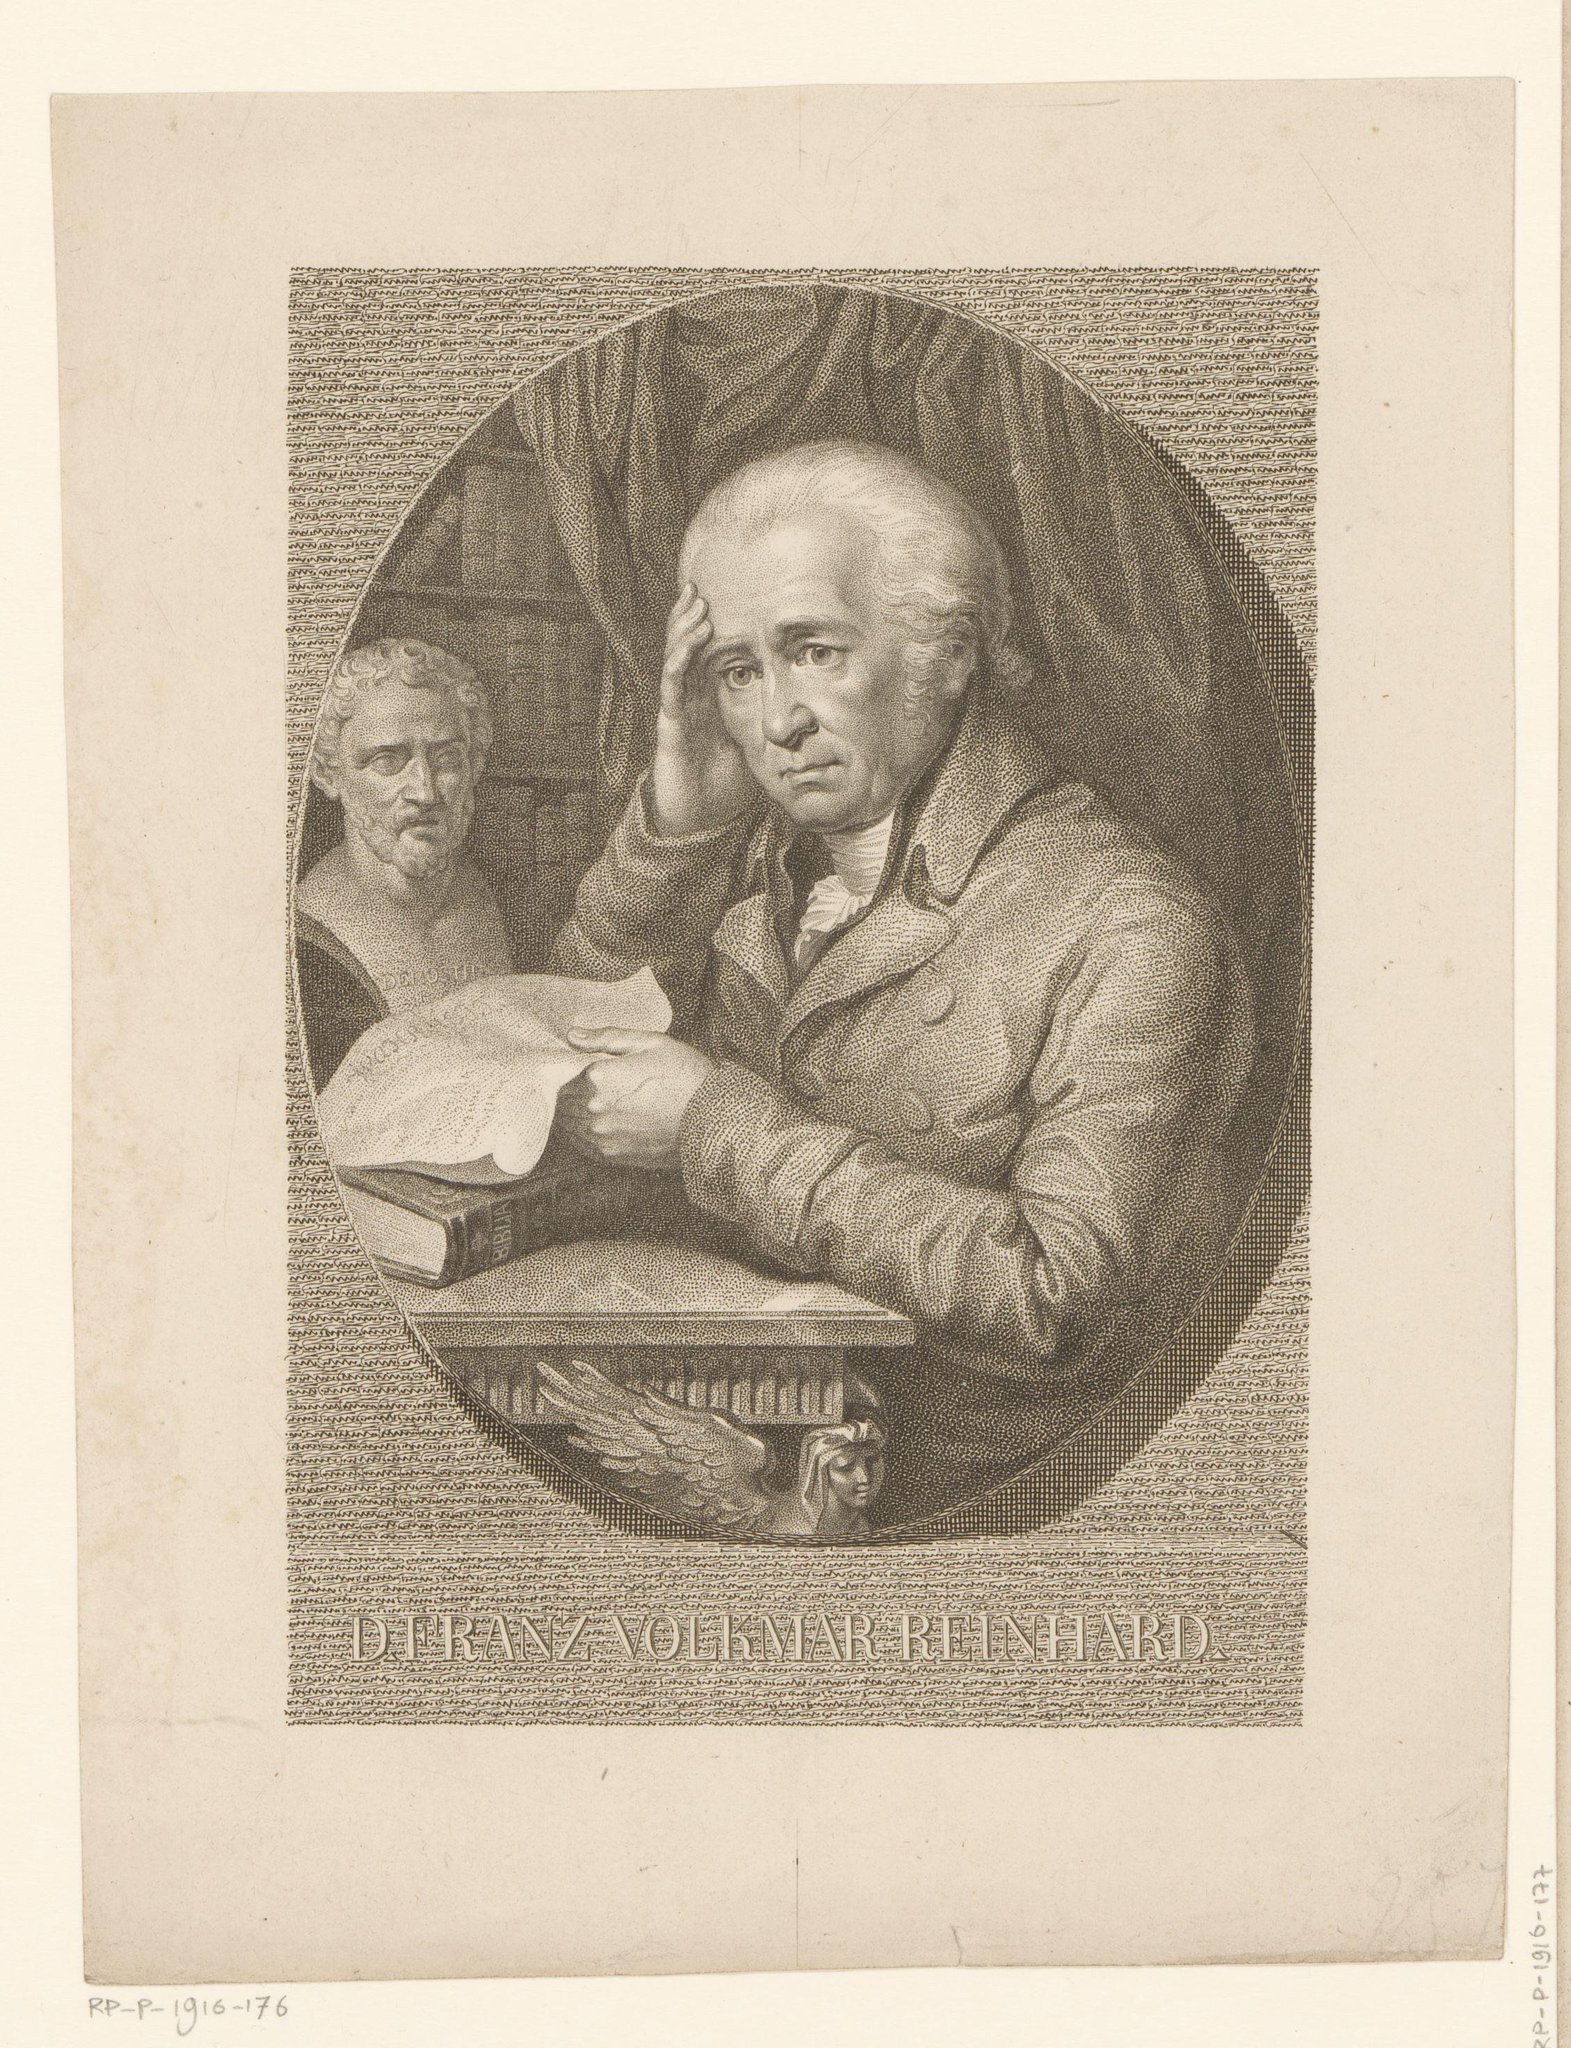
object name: print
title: Portret van Franz Volkmar Reinhard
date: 1790-1816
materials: paper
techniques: etching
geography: dresden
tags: bookshelves, historical persons, piece of sculpture, reproduction of a piece of sculpture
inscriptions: collector's mark: Lugt 2228